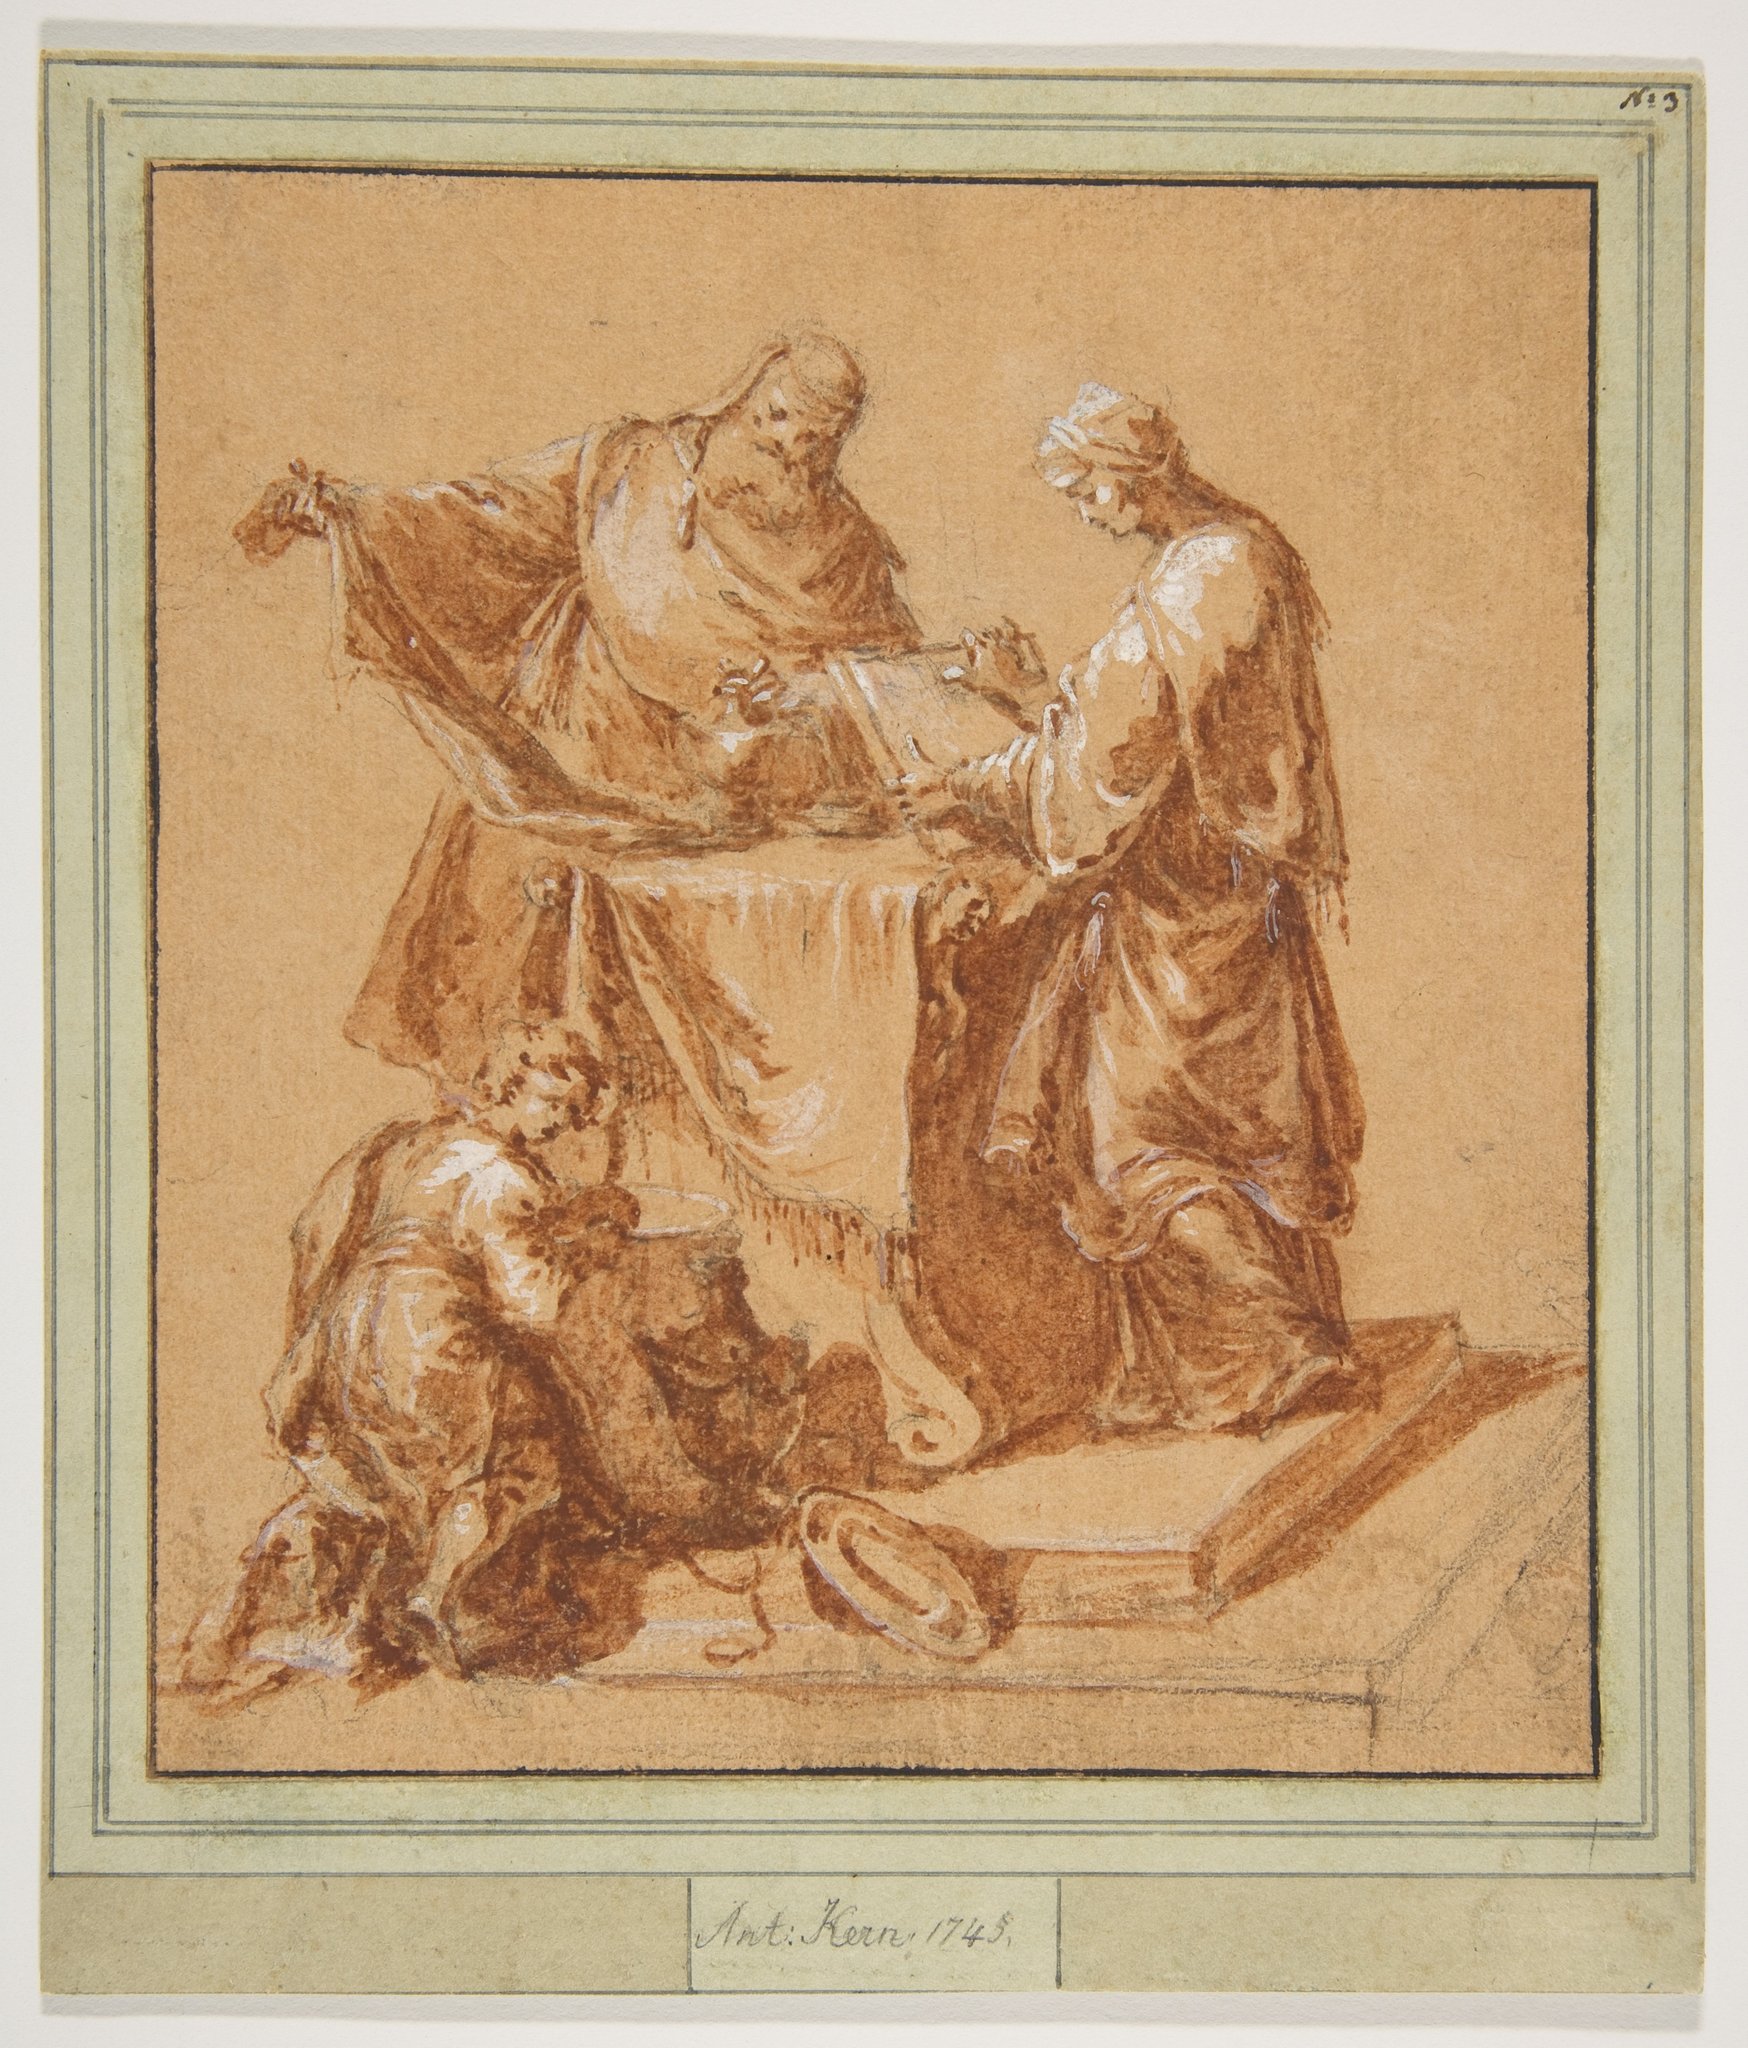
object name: drawing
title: A High-Priest, the Prophetess Anna (?) and a Kneeling Boy around a Table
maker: anton kern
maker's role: artist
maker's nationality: german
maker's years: 1710-1747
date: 1745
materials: paint, graphite, ink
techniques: brush, heightening, pen, wash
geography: germany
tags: boys,men,women